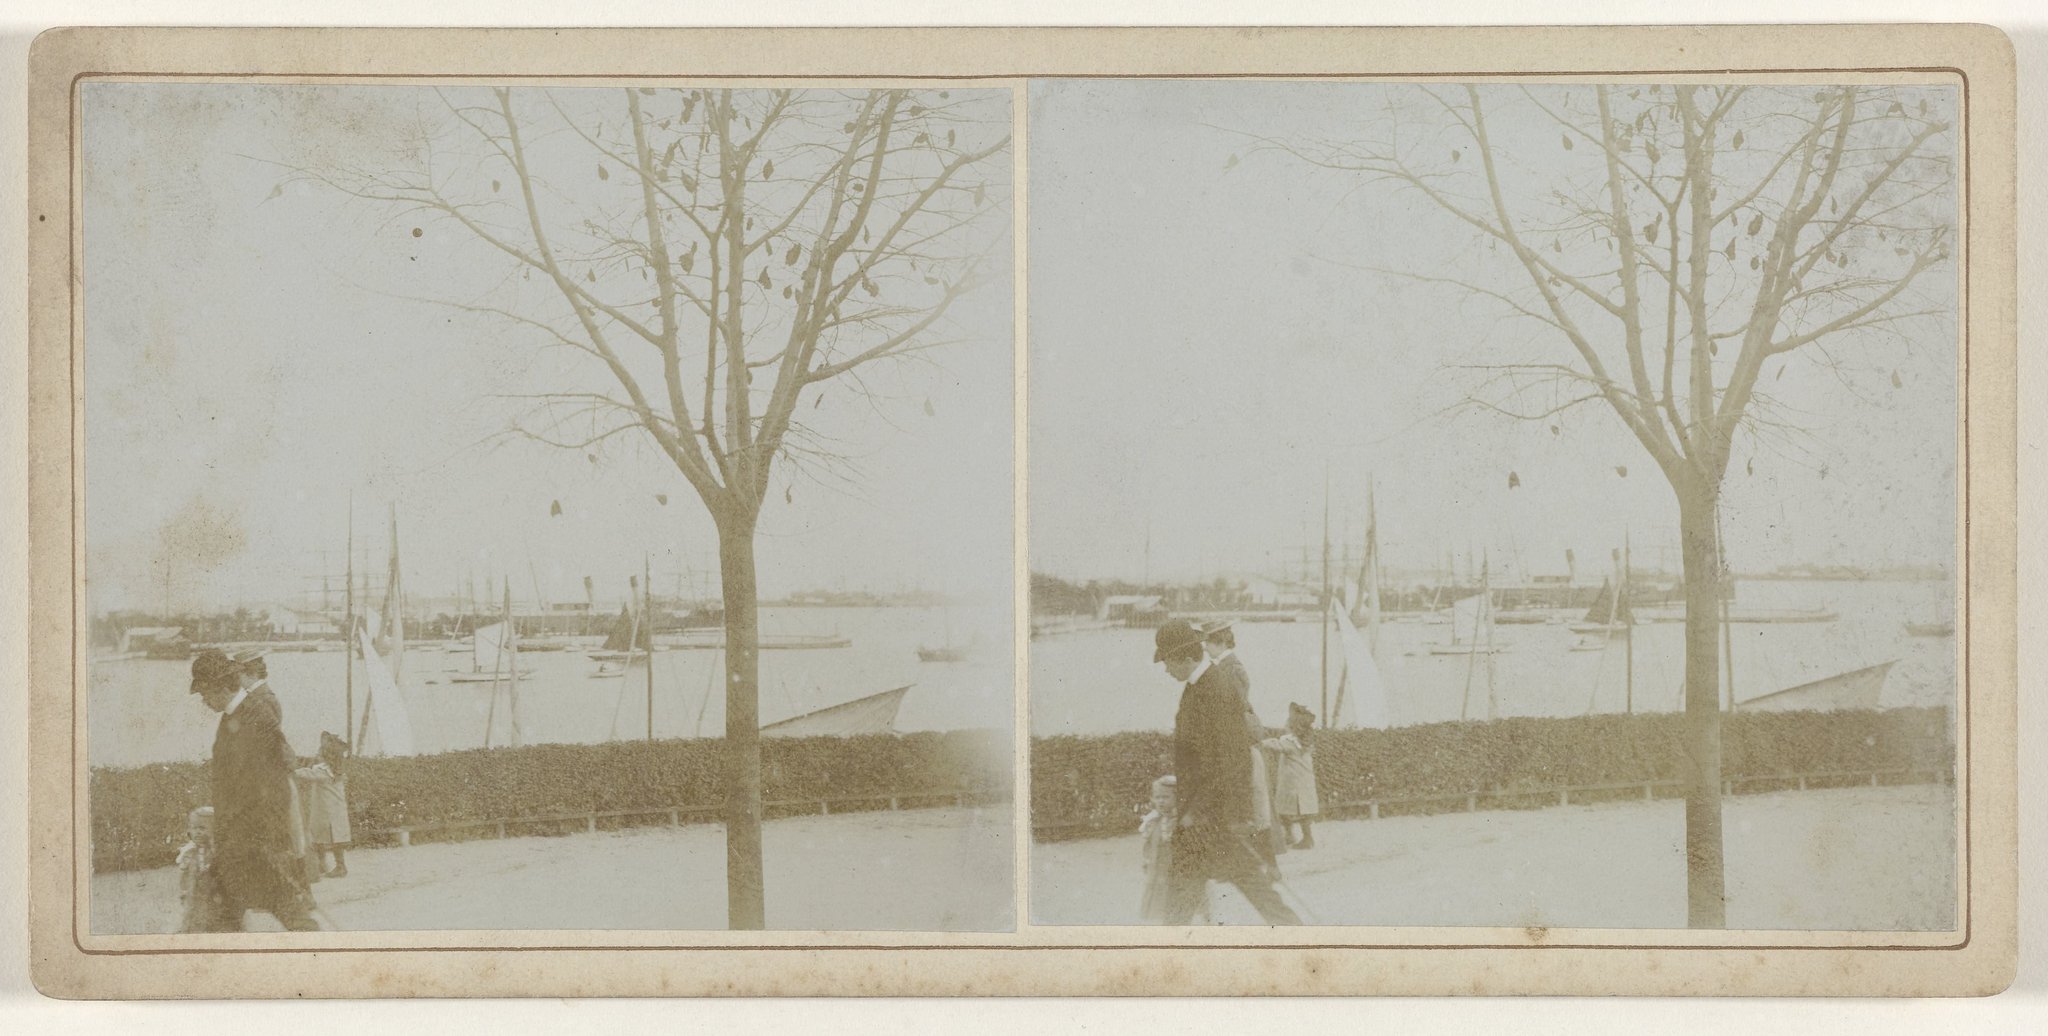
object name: stereograph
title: Havengezicht in Kopenhagen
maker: geldolph adriaan kessler (dolph)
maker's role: fotograaf, industrieel, voetballer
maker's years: 1884-1945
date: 1903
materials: paper, photographic support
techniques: collodion silver print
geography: netherlands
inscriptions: title: ‘Kopenhagen, aan de zeekant.’